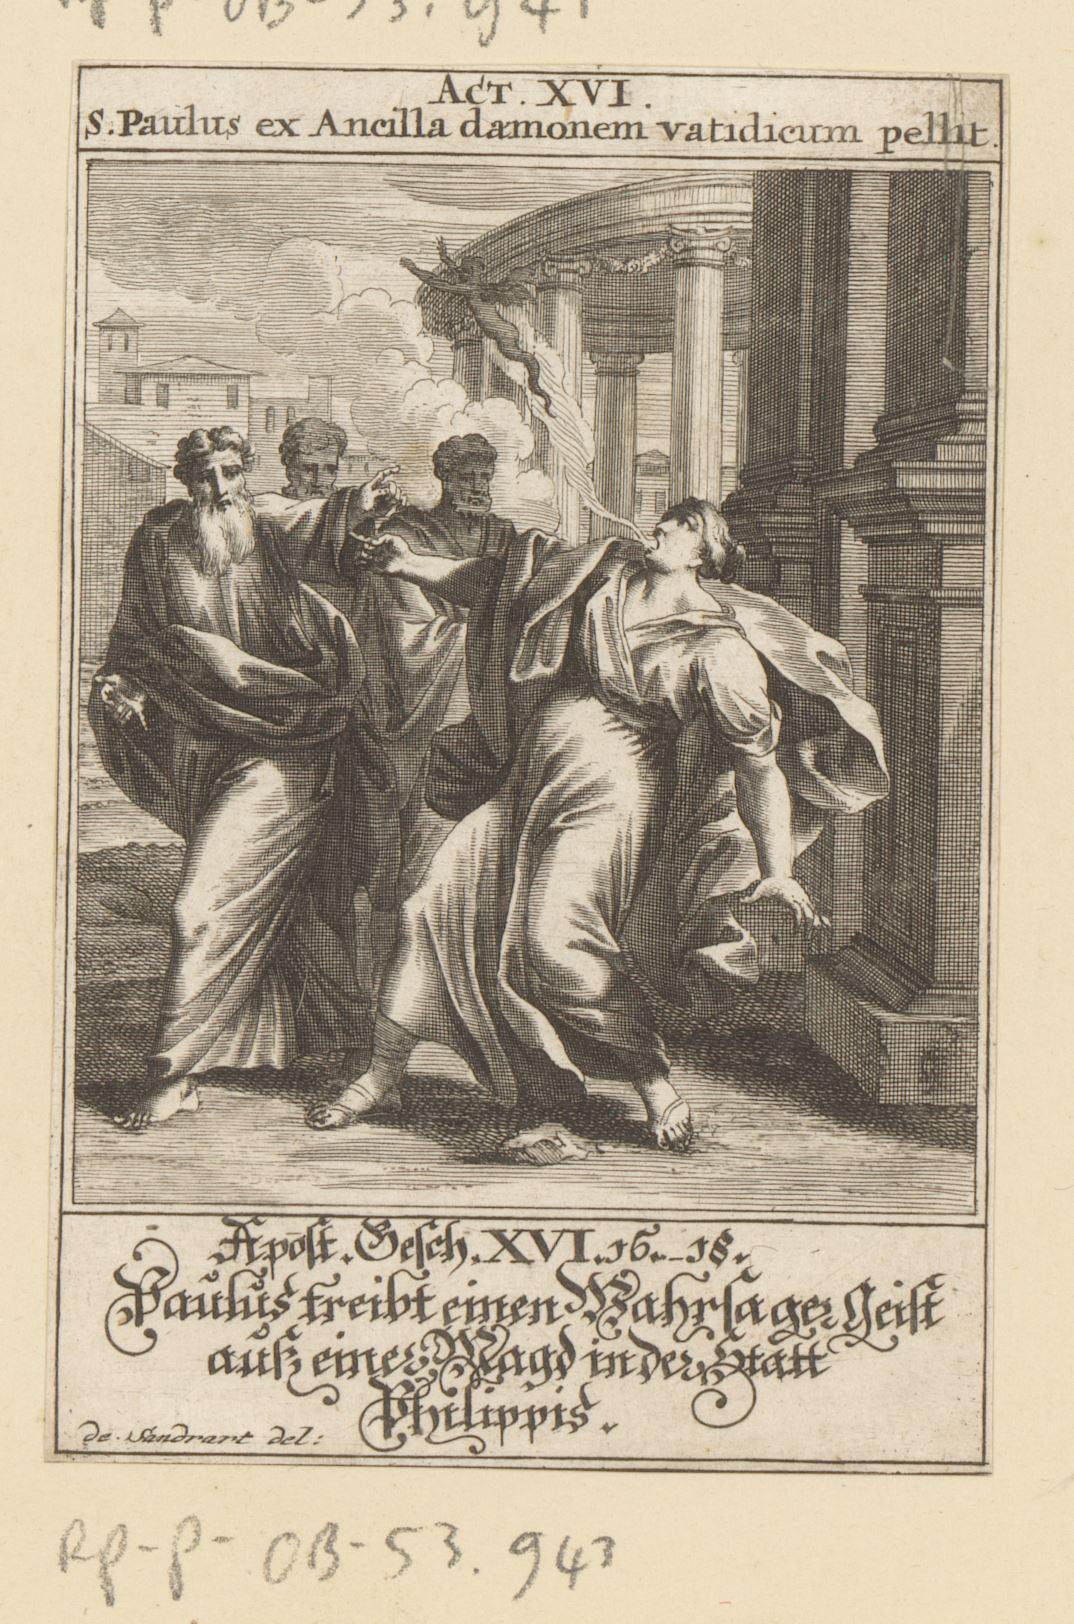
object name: print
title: Apostel Paulus verdrijft een boze geest uit de dienstmaagd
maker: Anonymous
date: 1697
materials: paper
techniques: etching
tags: exorcism, life and acts of paul (saul)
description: Prent ook gebruikt in: Biblia ectypa : Bildnussen auss Heiliger Schrifft. Regensburg: Chr. Wiegel, 1697.